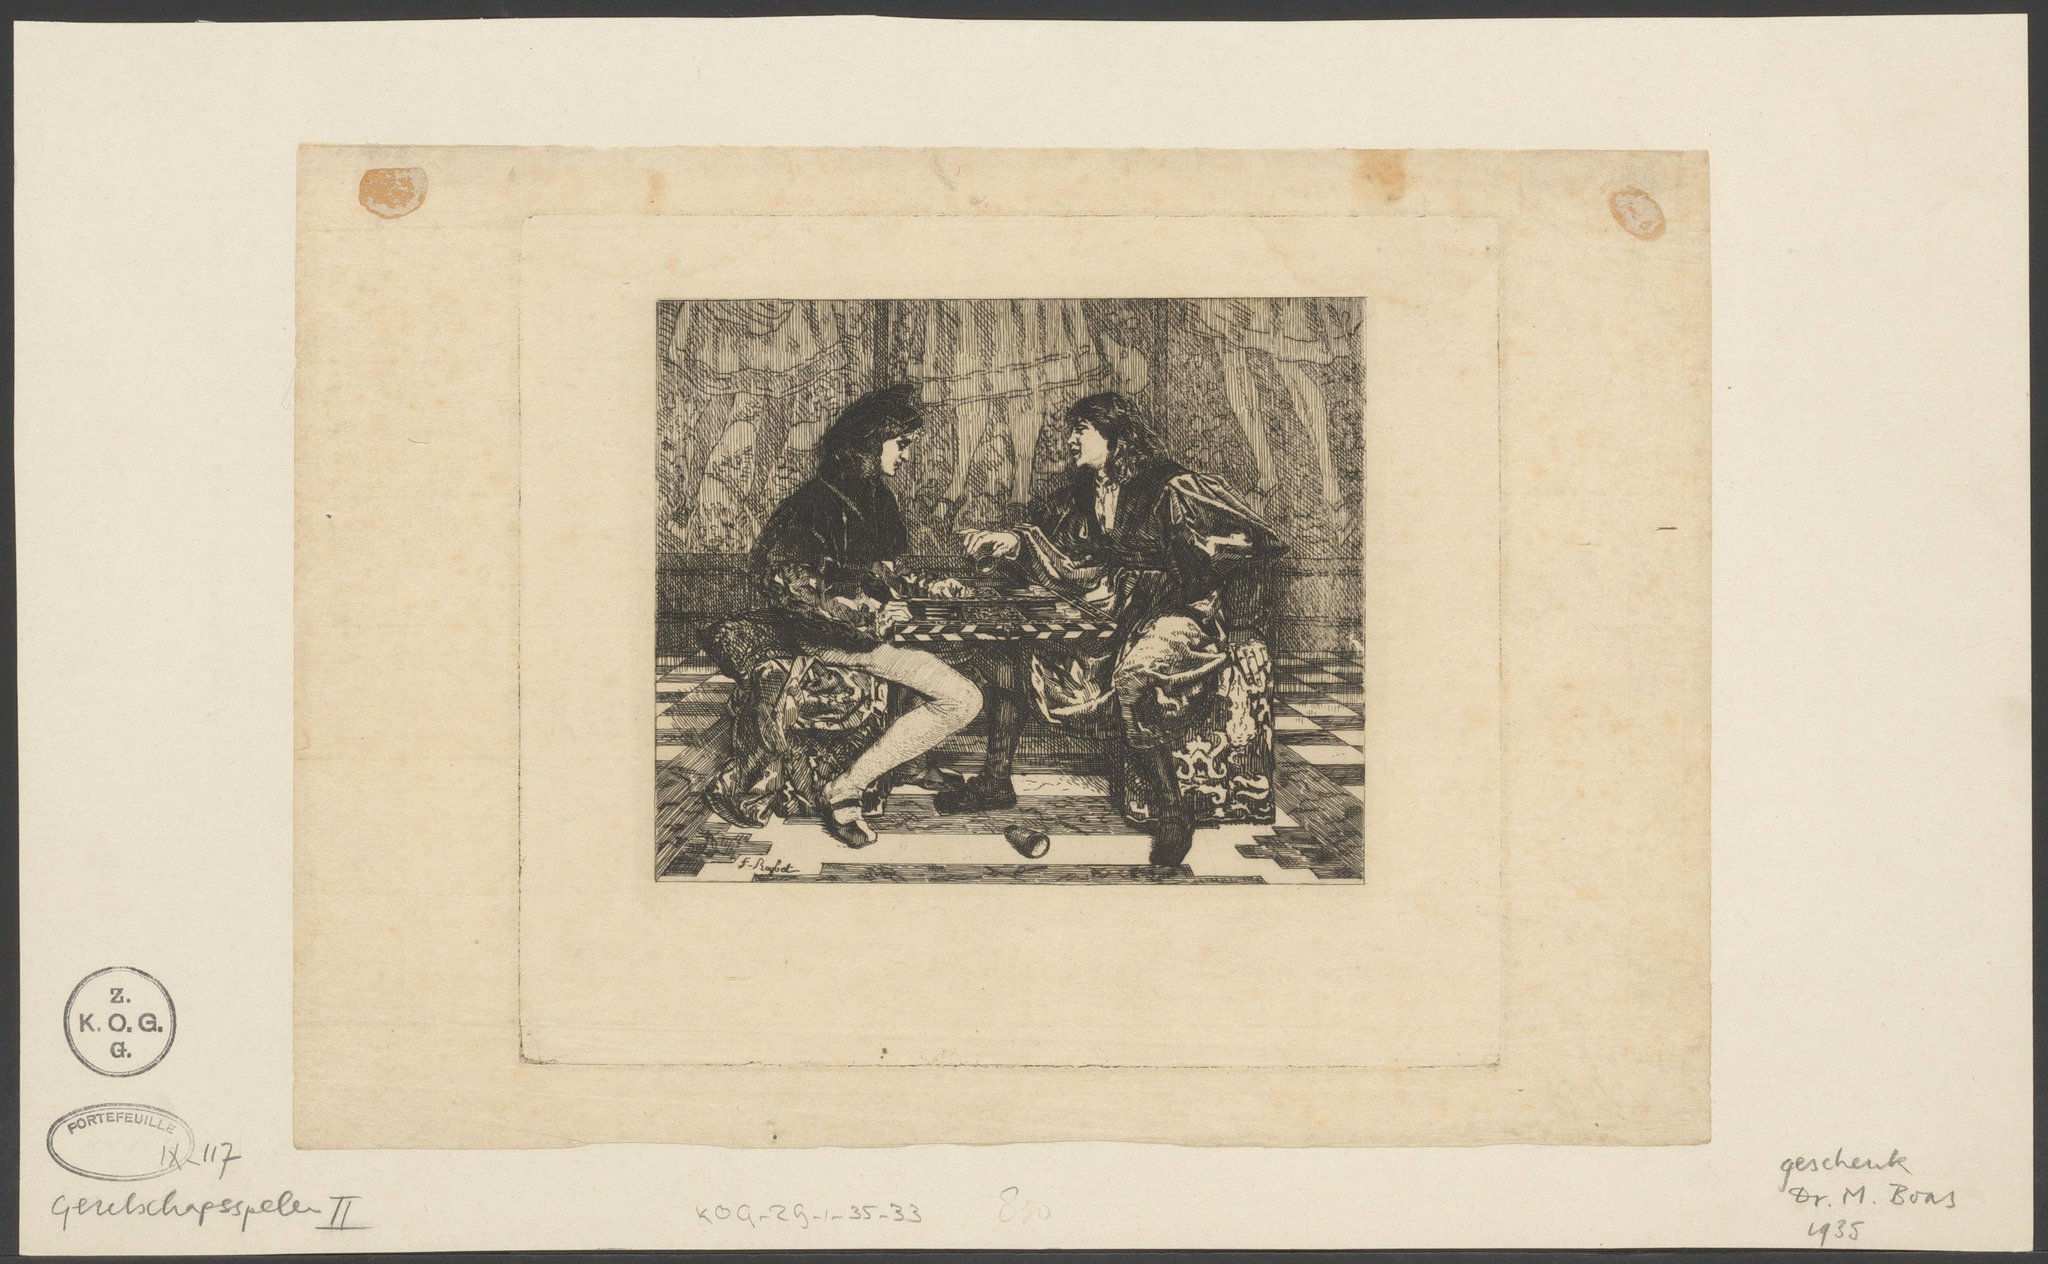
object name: print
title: Interieur met twee backgammon spelers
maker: ferdinand roybet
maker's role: draughtsman, print maker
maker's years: 1840-1920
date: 1850-1868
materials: paper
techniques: drypoint, etching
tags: backgammon, tric-trac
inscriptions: collector's mark: Lugt 1641, stamp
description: Twee tric trac spelers in zestiende-eeuws kostuum van opzij gezien aan een tafel. Onderwerpsrubrieken binnen de Atlas Zeden en Gewoonten: Zeden en gewoonten in engeren zin, Spel en vermaak, Gezelschapsspel II, Ganzenbord en dergelijke.